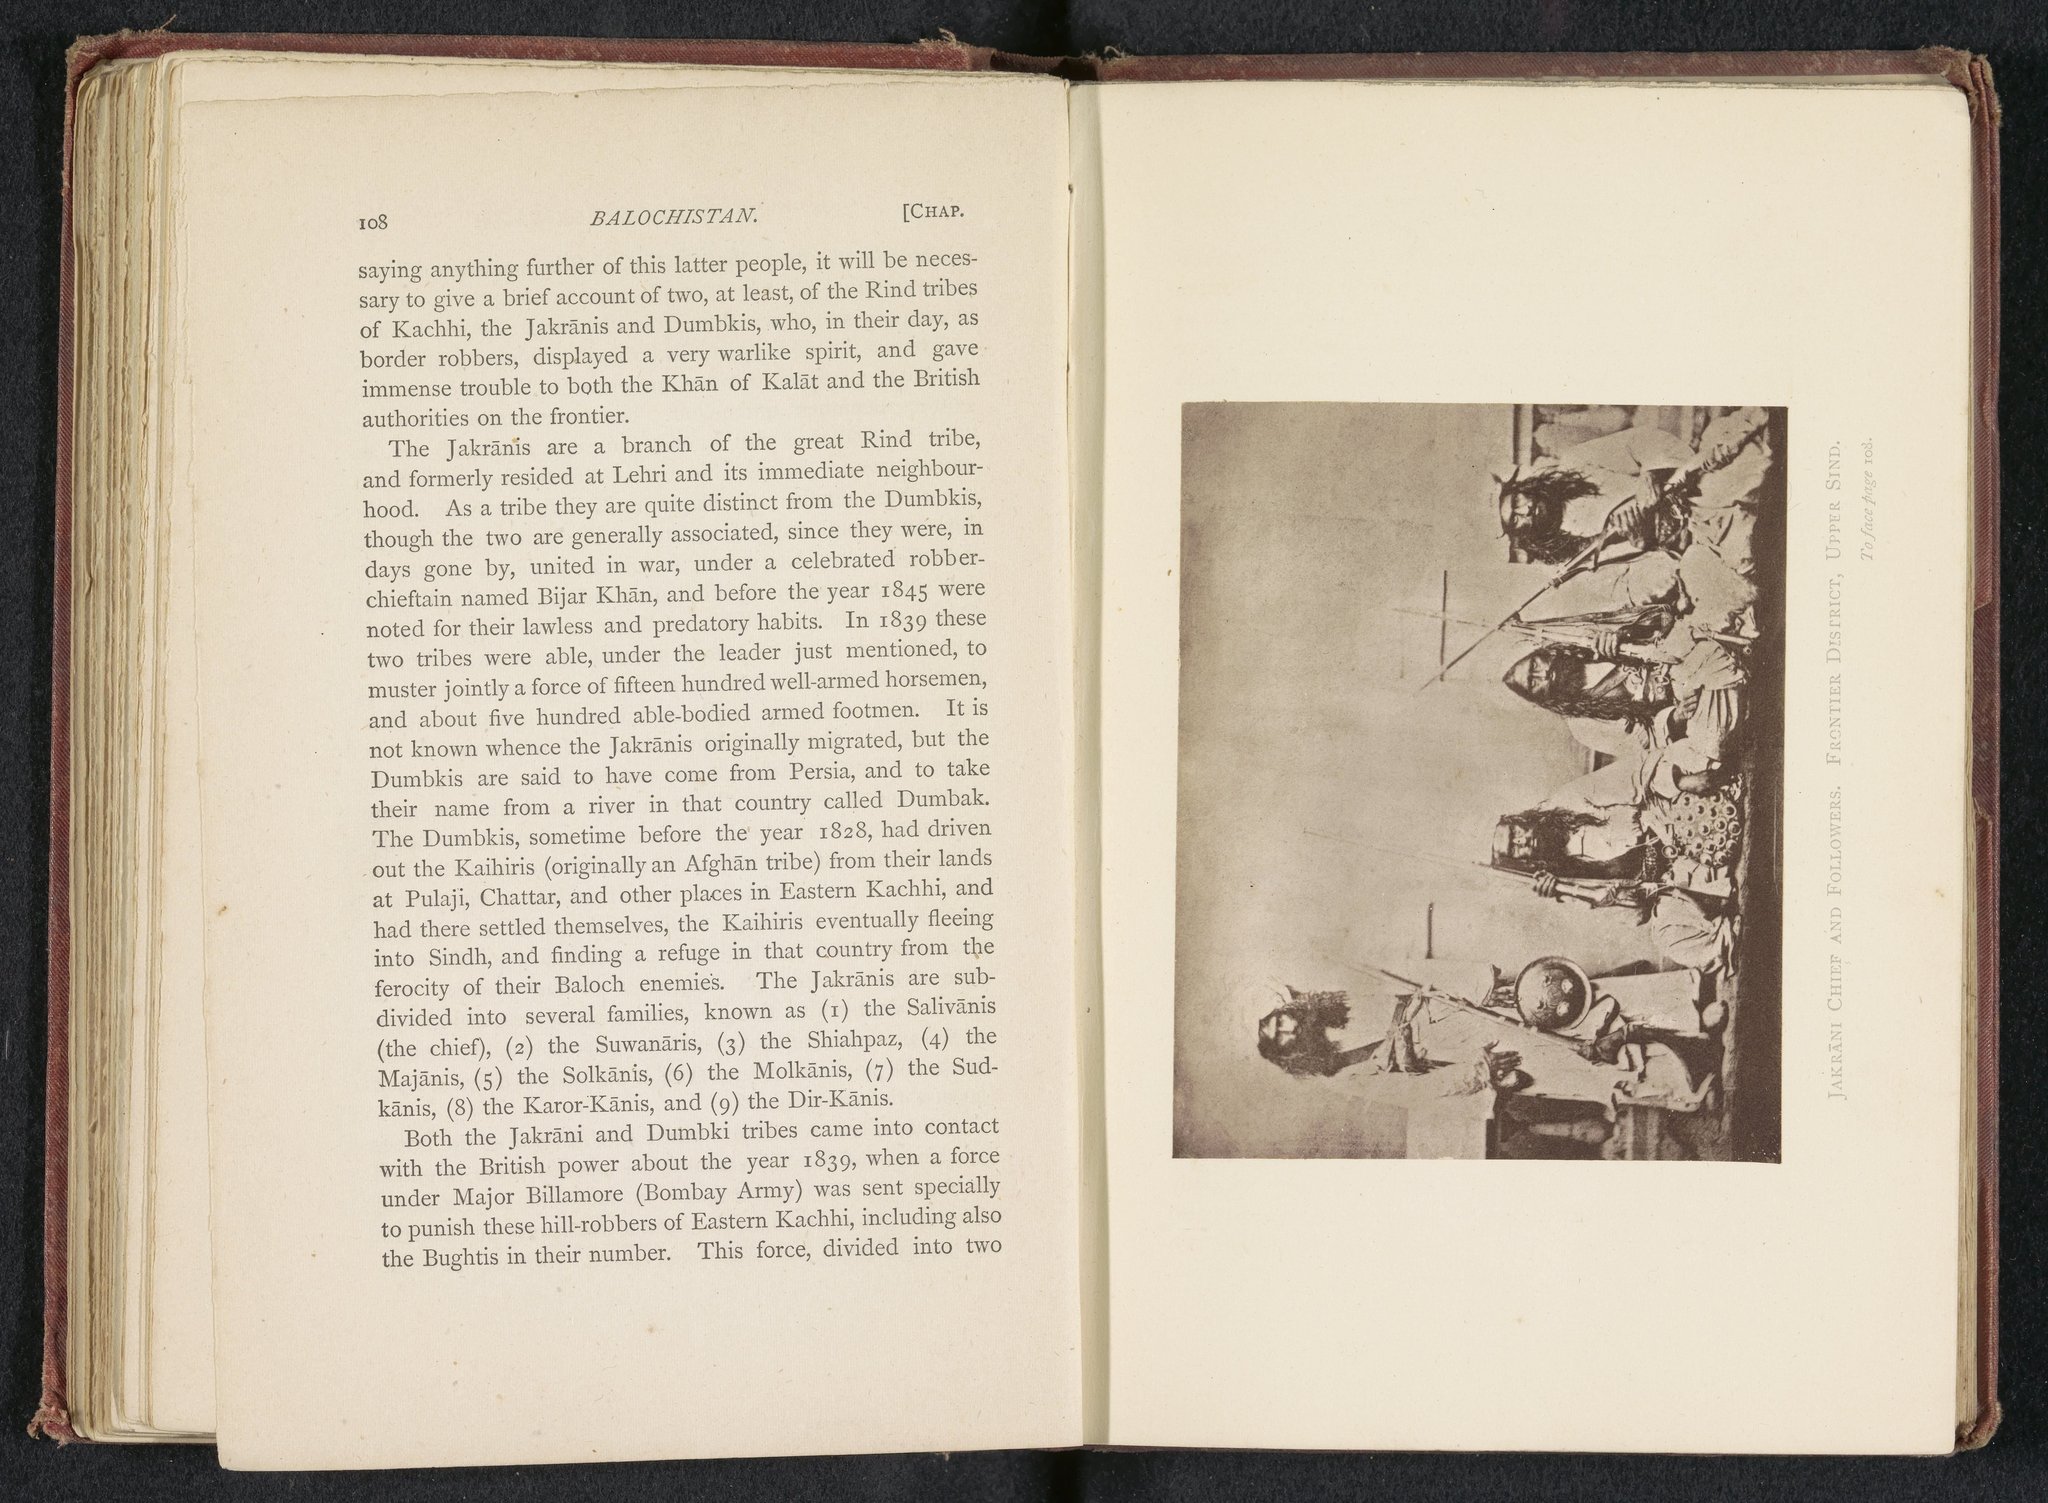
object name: photomechanical print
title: Jakrāni chief and followers. Frontier District, Upper Sind.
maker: Anonymous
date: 1866-1876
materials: paper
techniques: woodburytype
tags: firearms: rifle, ruler, sovereign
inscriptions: inscription: ‘To face page 108.’